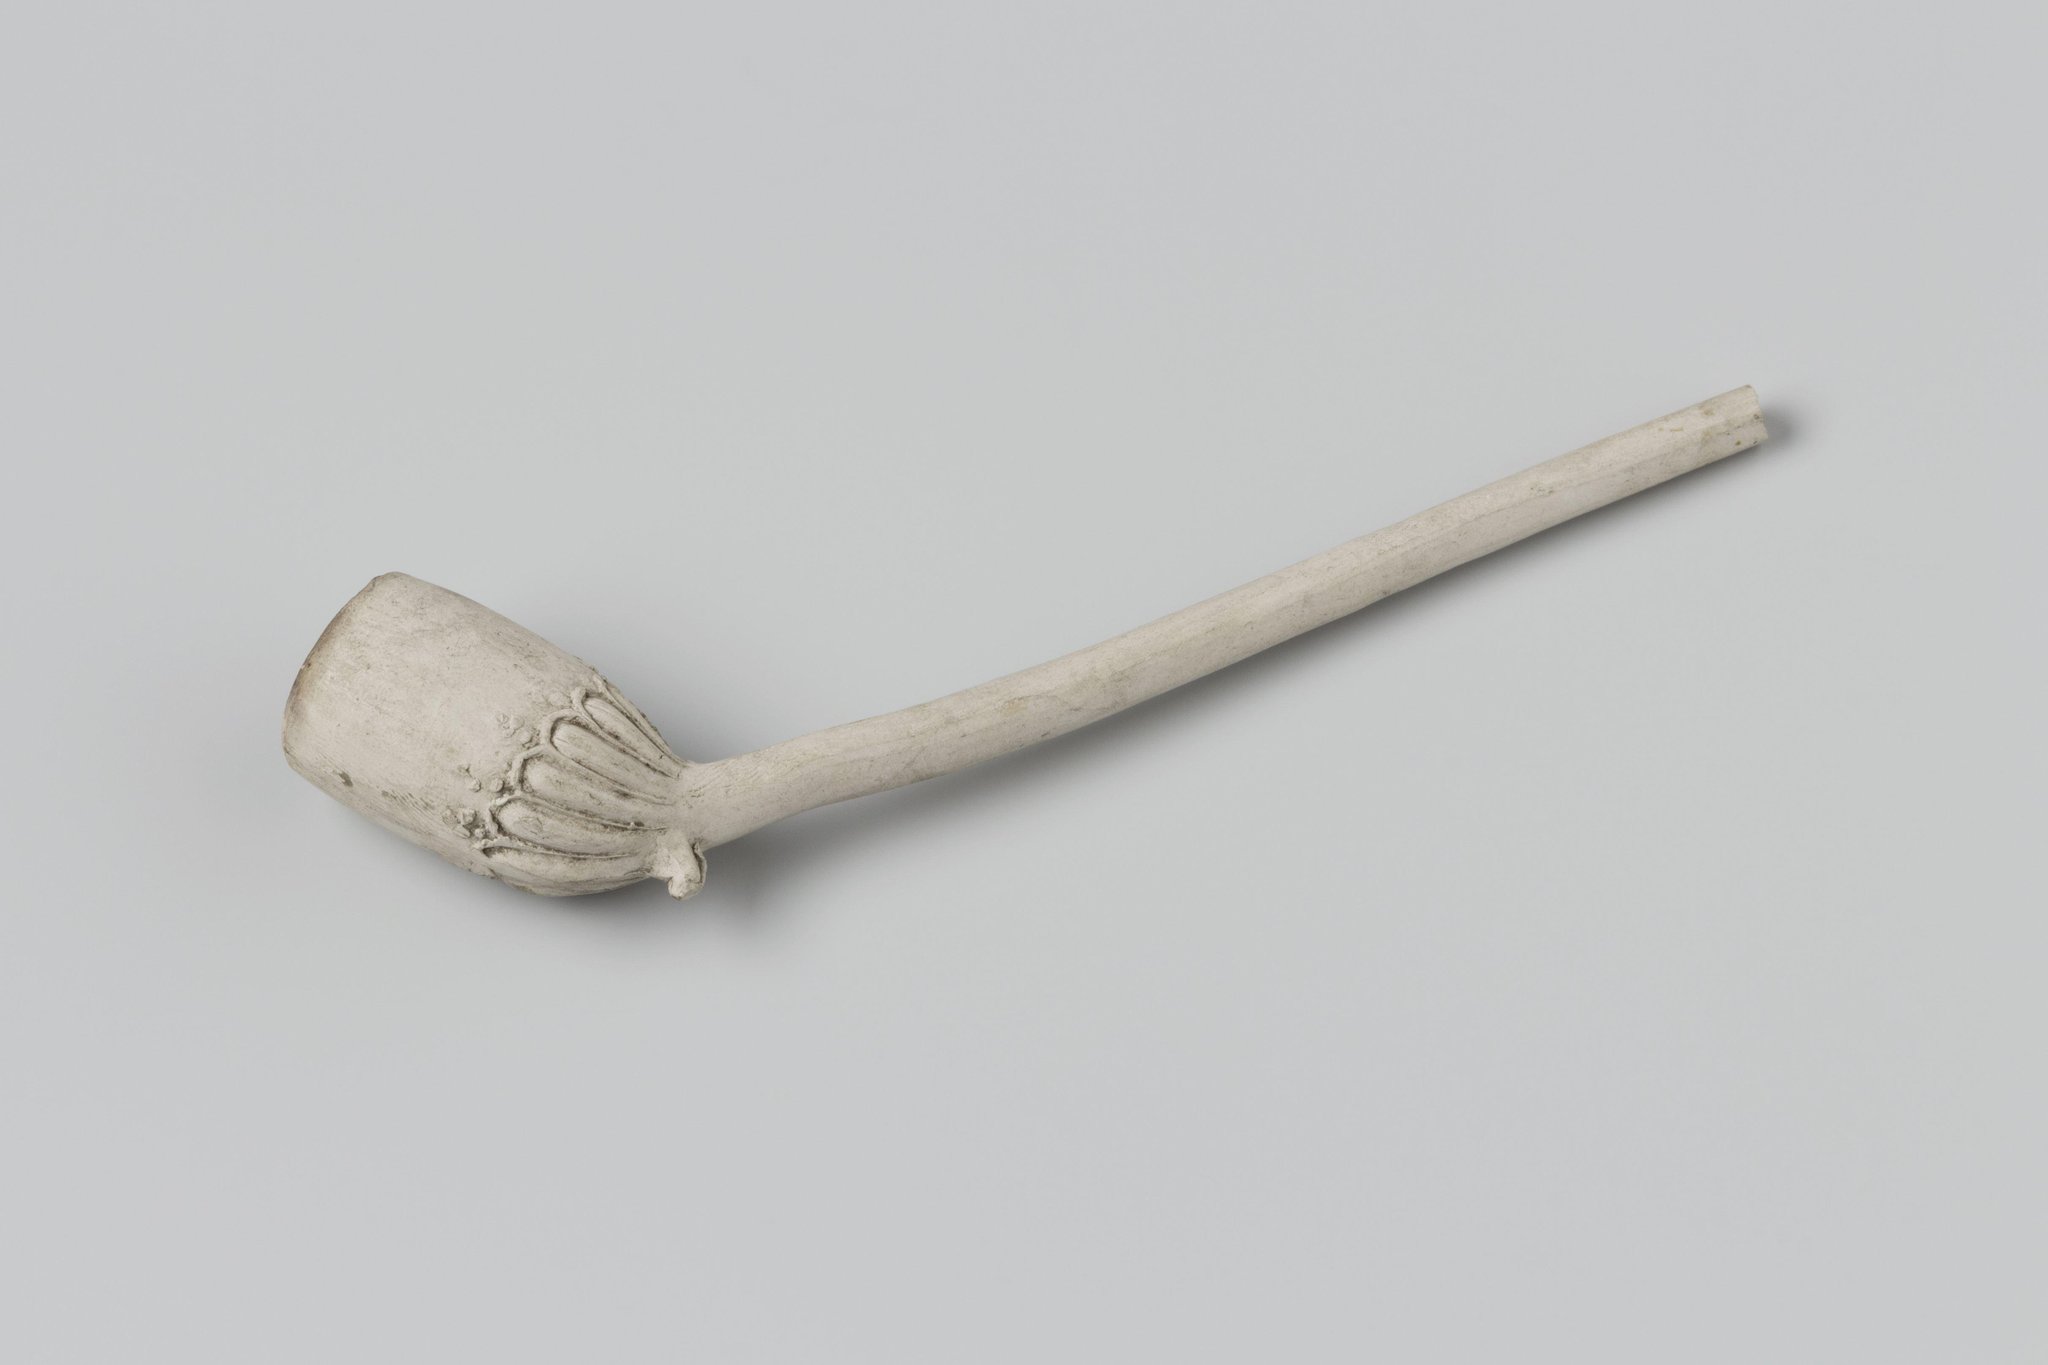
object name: fragment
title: Fragment tabakspijp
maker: Anonymous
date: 1750-1780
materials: clay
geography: netherlands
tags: directeur, hoogleraar, caspar jacob christiaan reuvens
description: Fragment tabakspijp met twaalf knorren met omlijningen (floraal uitwaaiend motief) en bladmotiefjes. Van de opgravingen op de Hofstede Arentsburg 1827-1831 onder toezicht van Professor Reuvens.